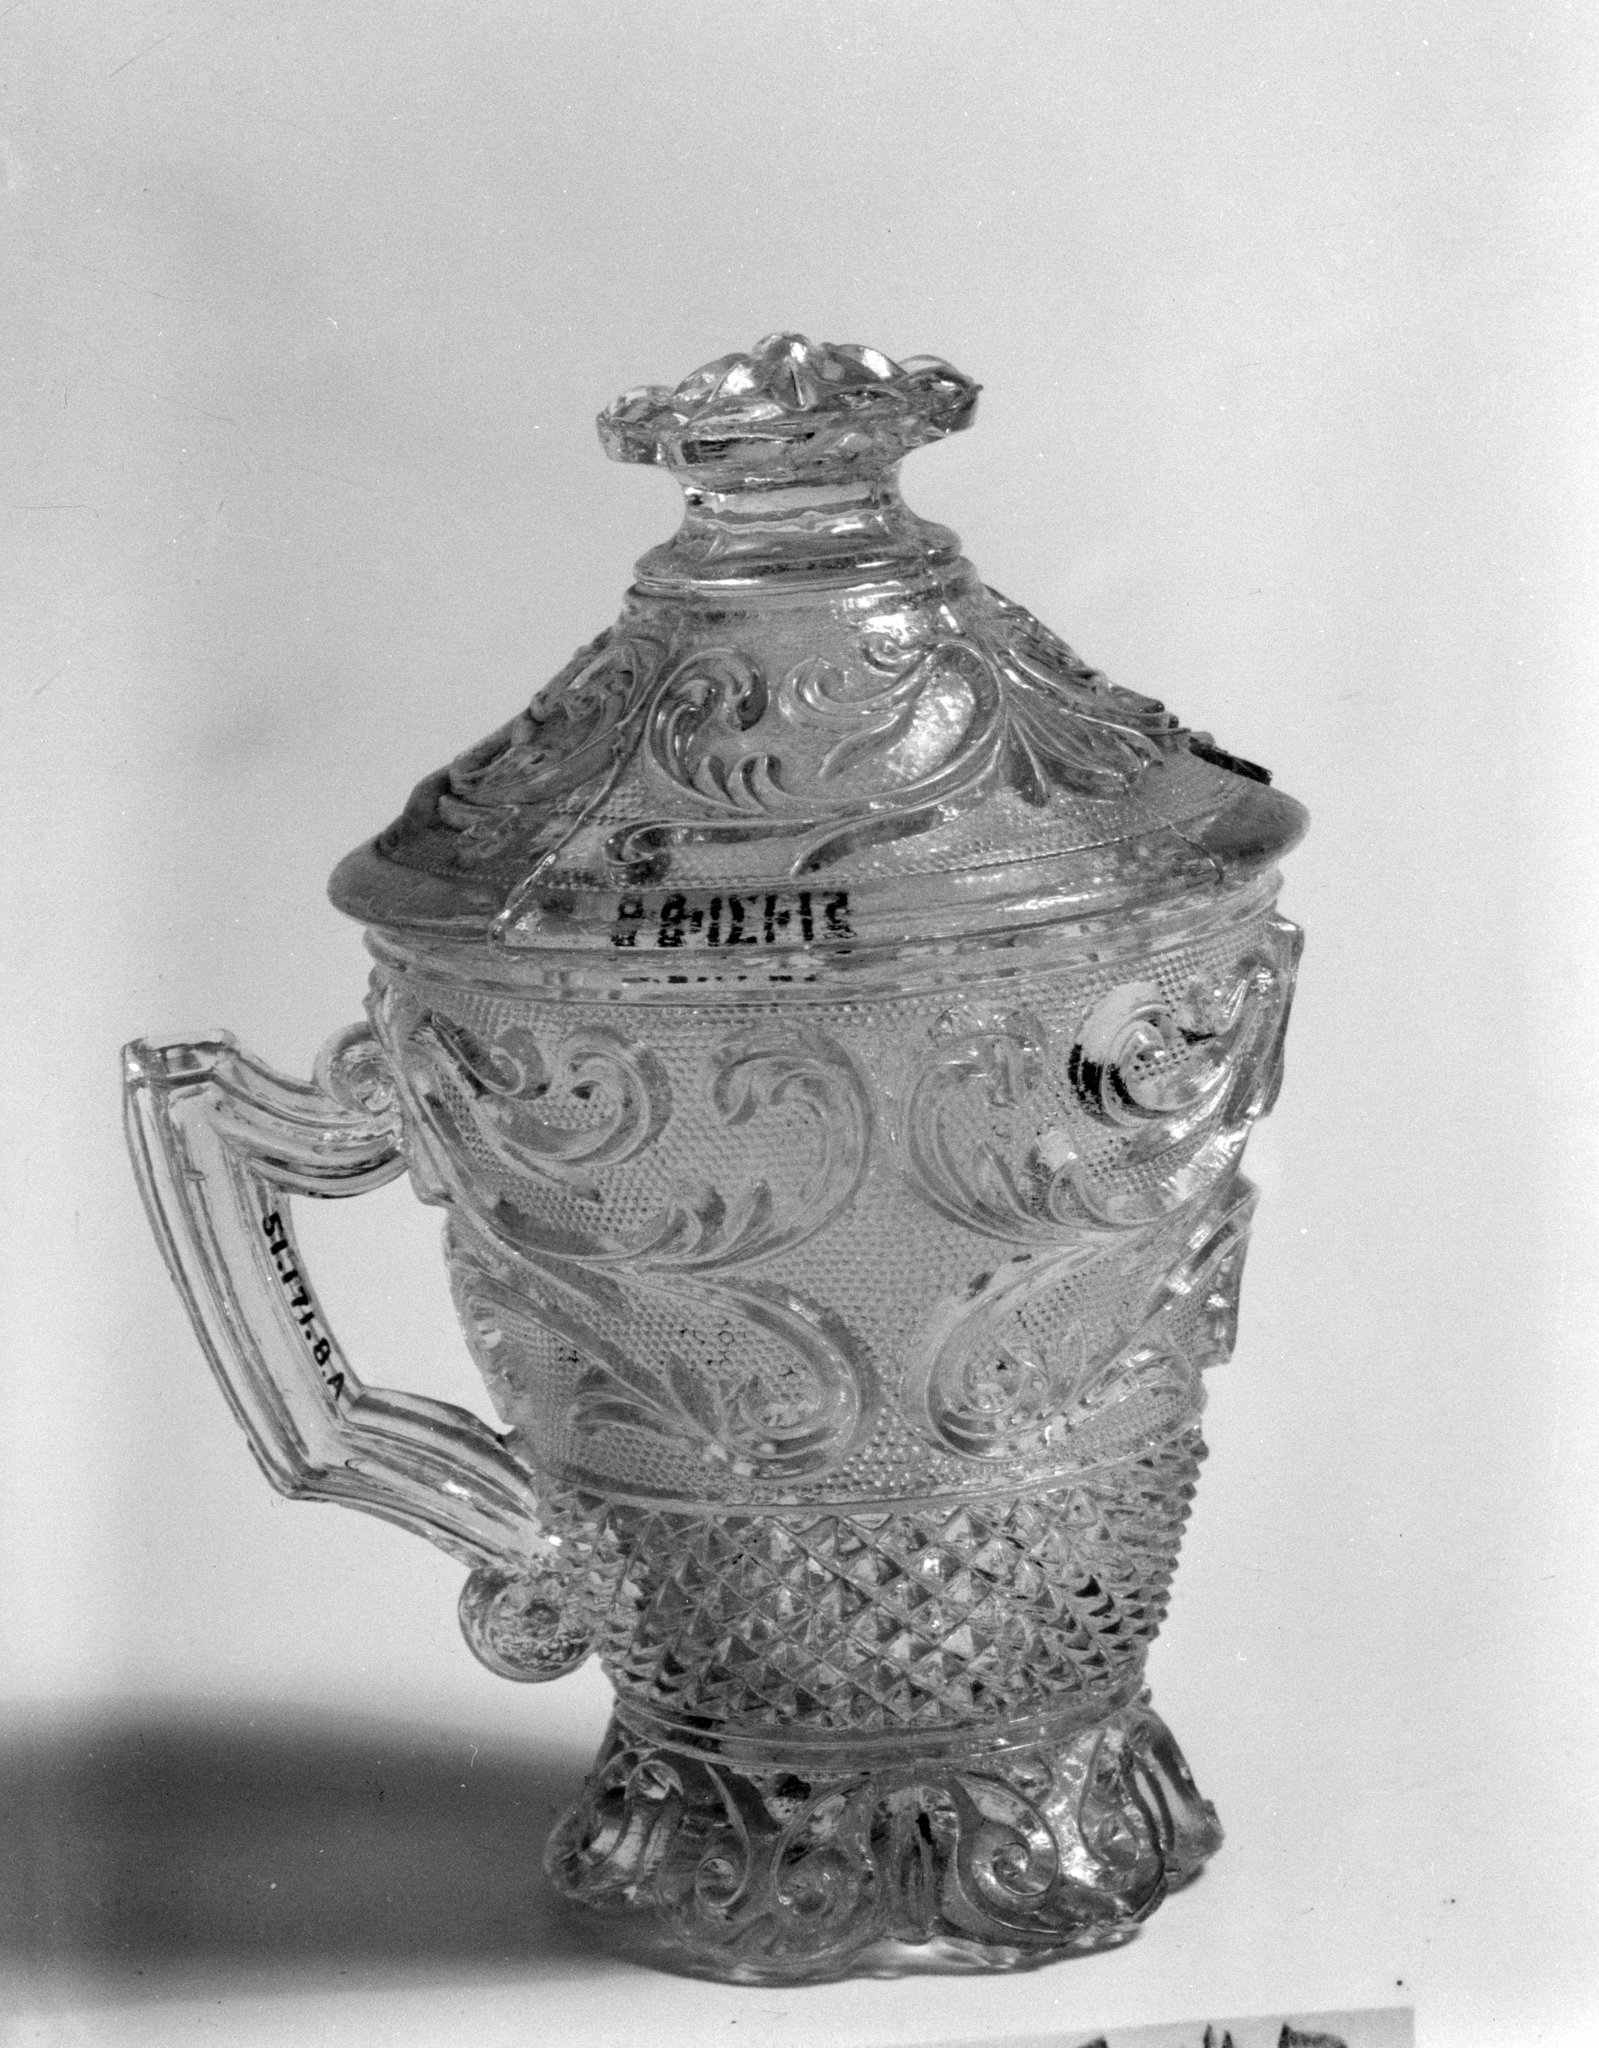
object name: mustard pot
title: Covered Mustard Pot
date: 1830-1900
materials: glass